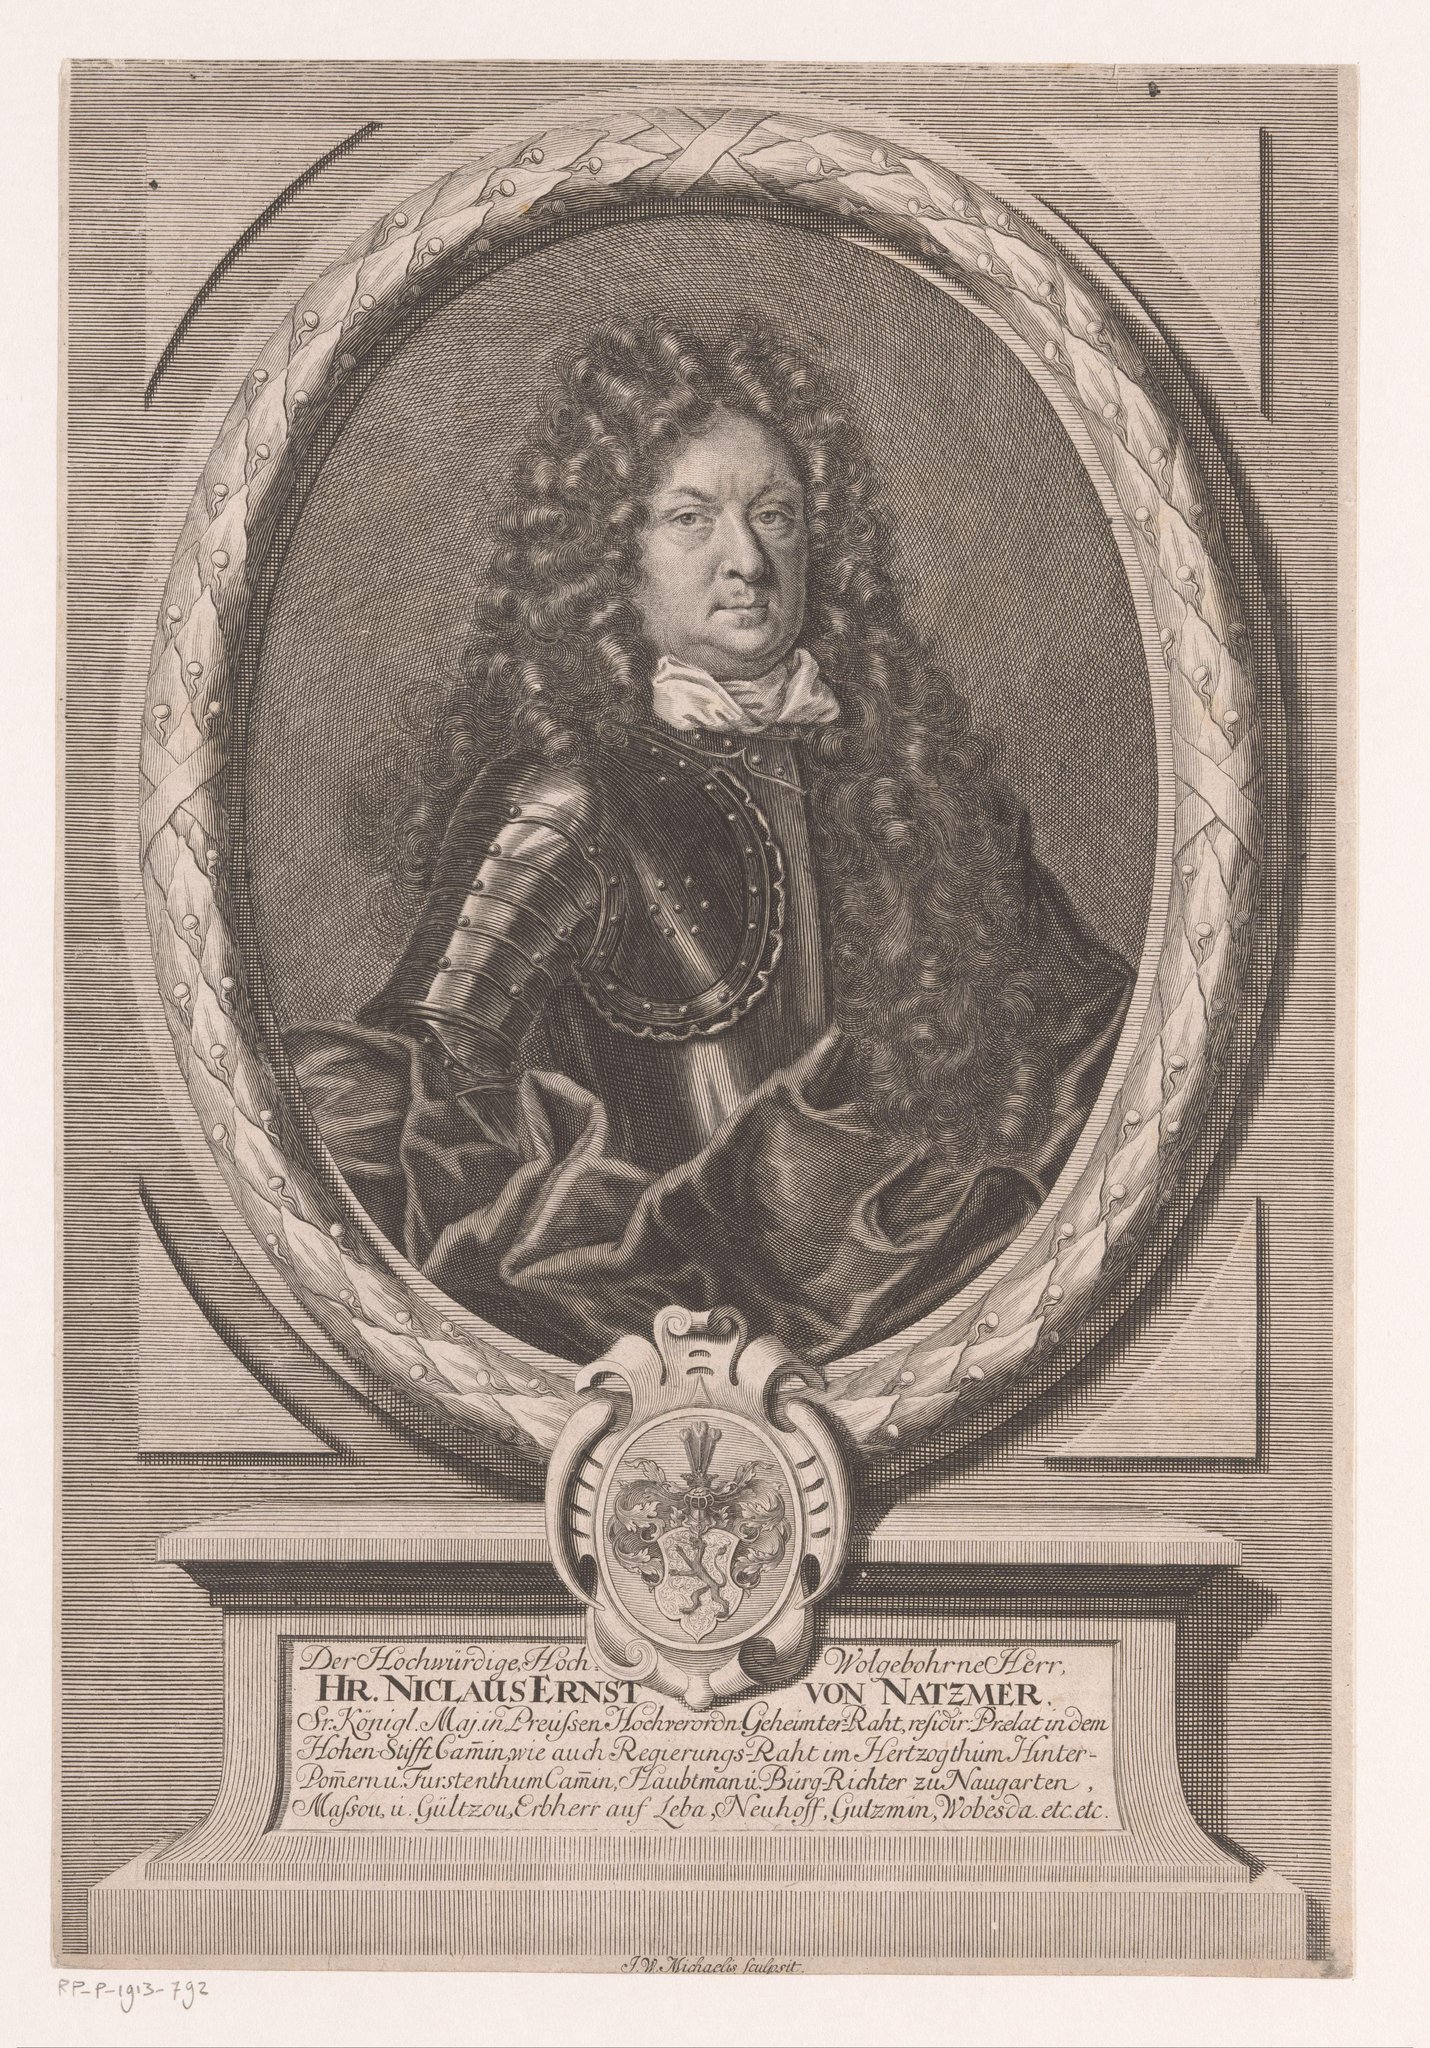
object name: print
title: Portret van Nicolaus Ernst von Natzmer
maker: johann wilhelm michaelis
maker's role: print maker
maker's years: -1737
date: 1685-1737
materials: paper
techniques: engraving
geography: germany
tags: armour, historical persons, armorial bearing, heraldry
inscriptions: collector's mark: Lugt 2228